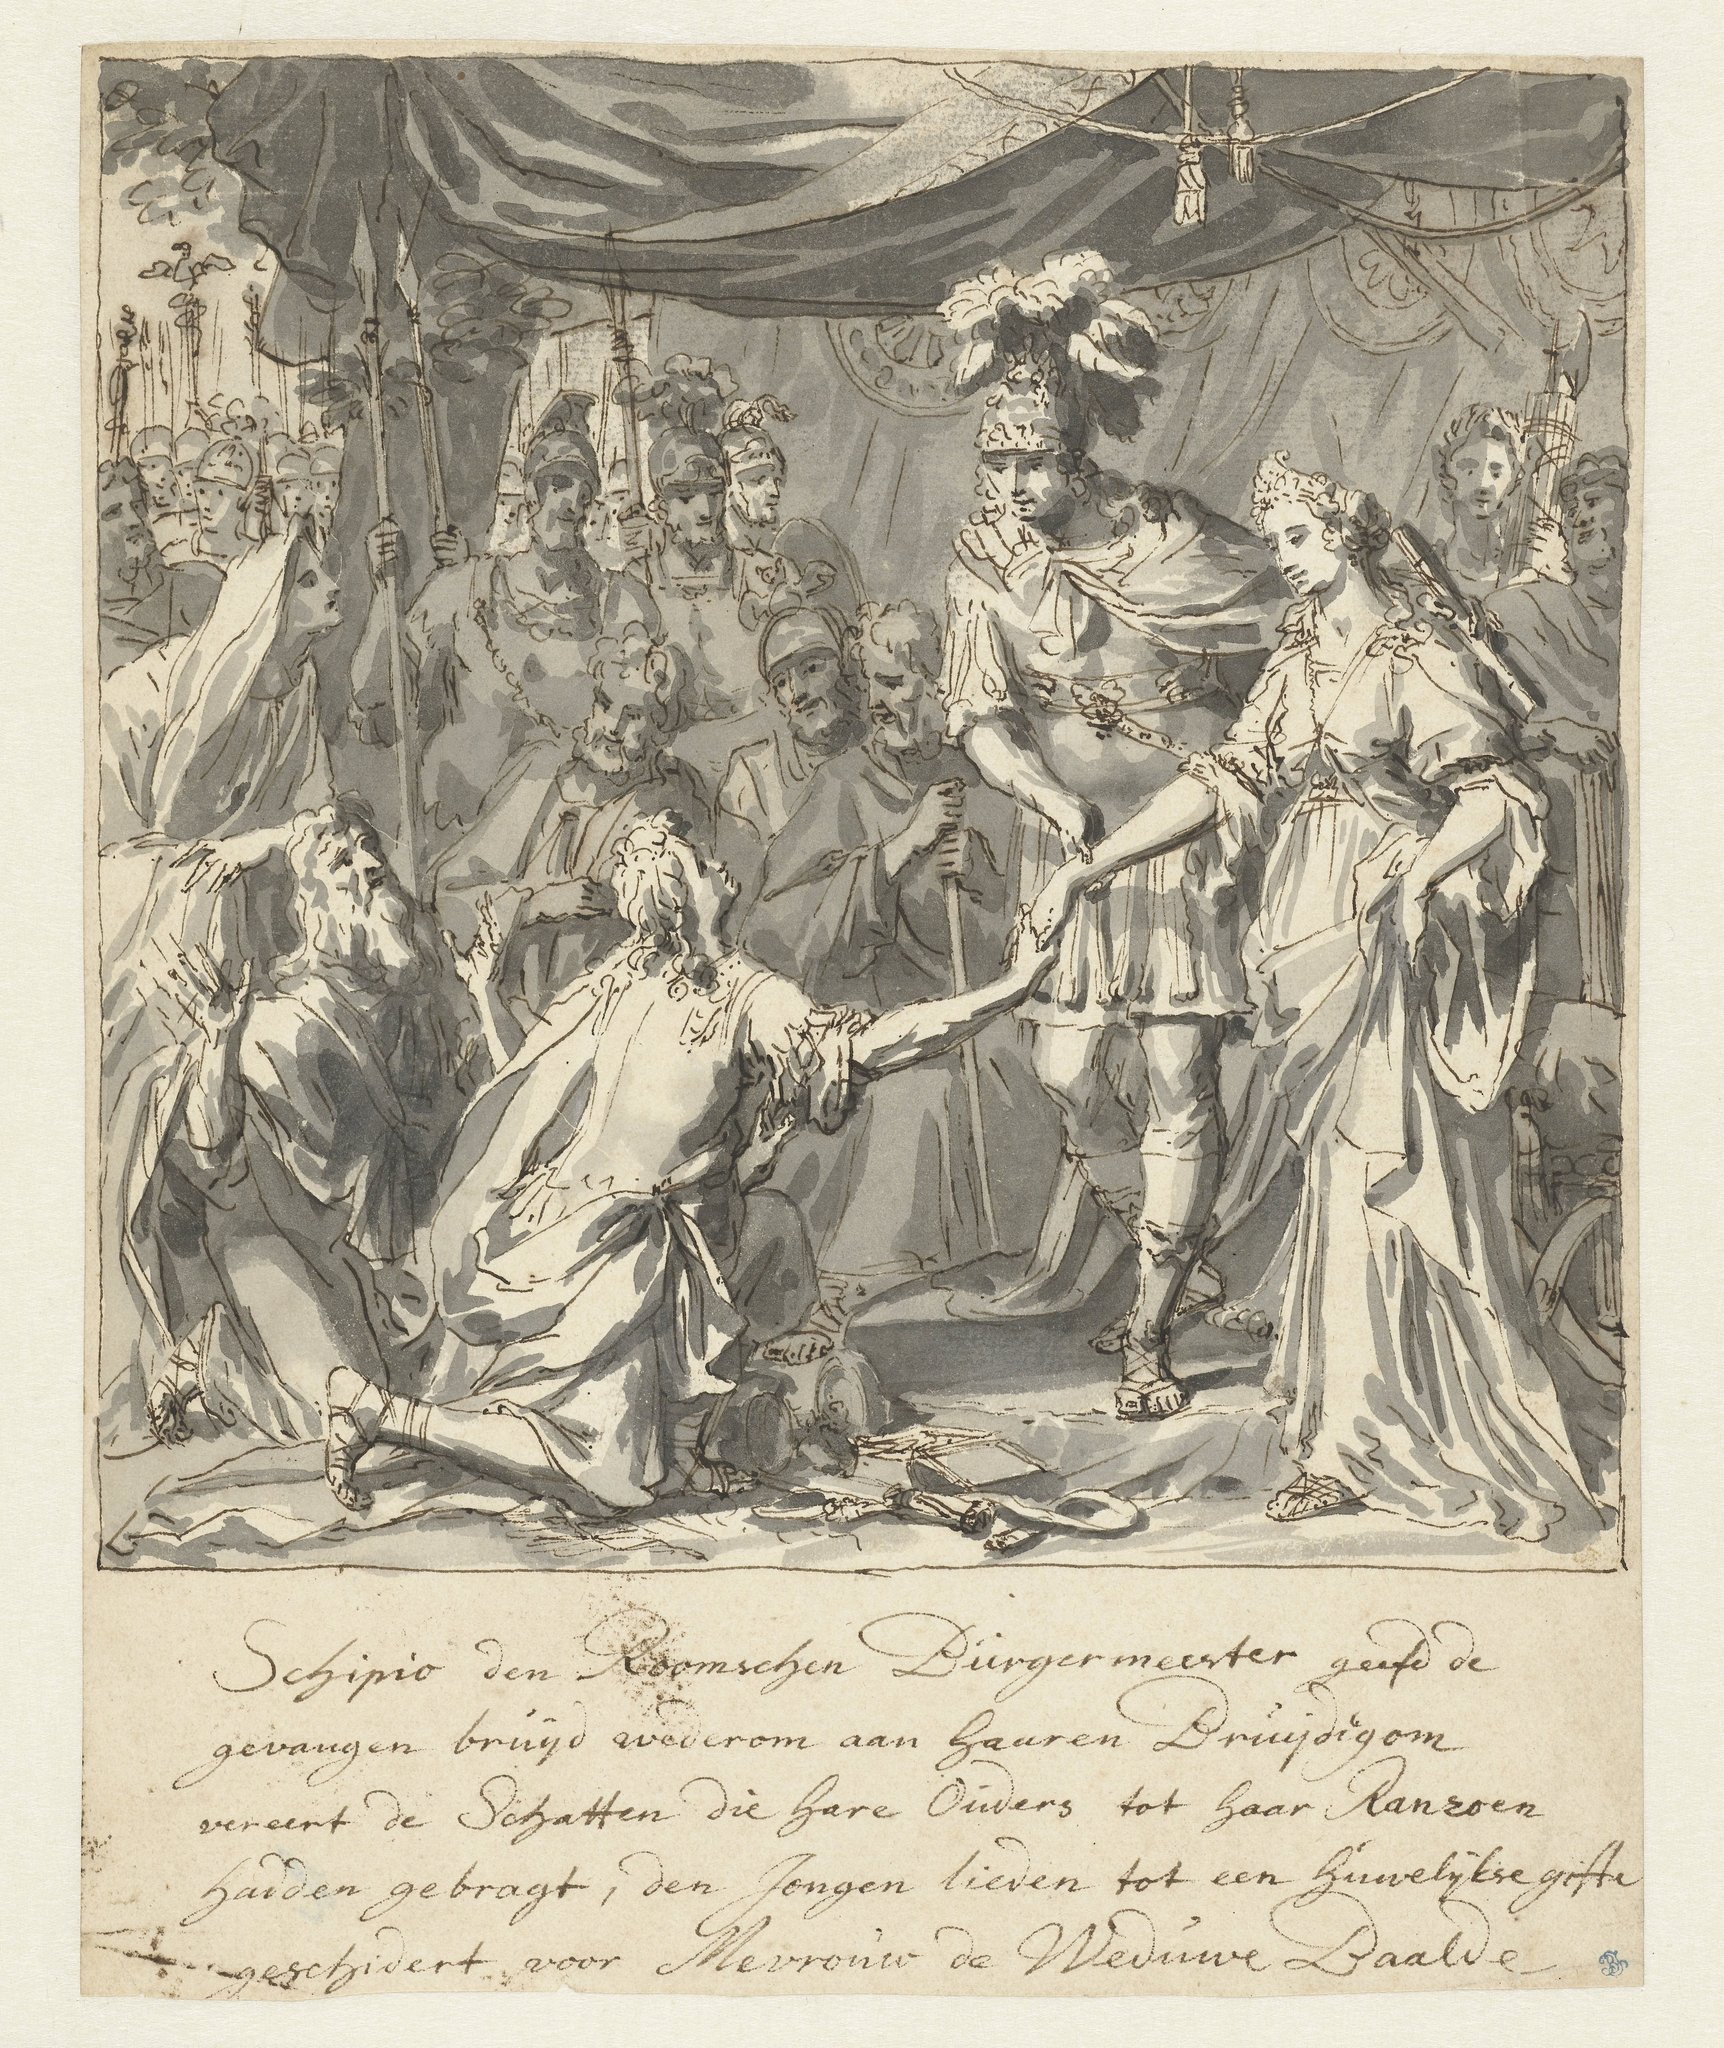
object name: drawing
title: De grootmoedigheid van Scipio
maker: philip tidemann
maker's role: draughtsman, painter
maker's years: 1657-1705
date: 1667-1705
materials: ink, paper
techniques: brush, pen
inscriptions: inscription: ‘Schipio den Roomschen Burgemeester geefd de gevangen bruyd wederom aan haaren Bruydegom [...] geschidert voor Mevrouw de Weduwe Baalde’